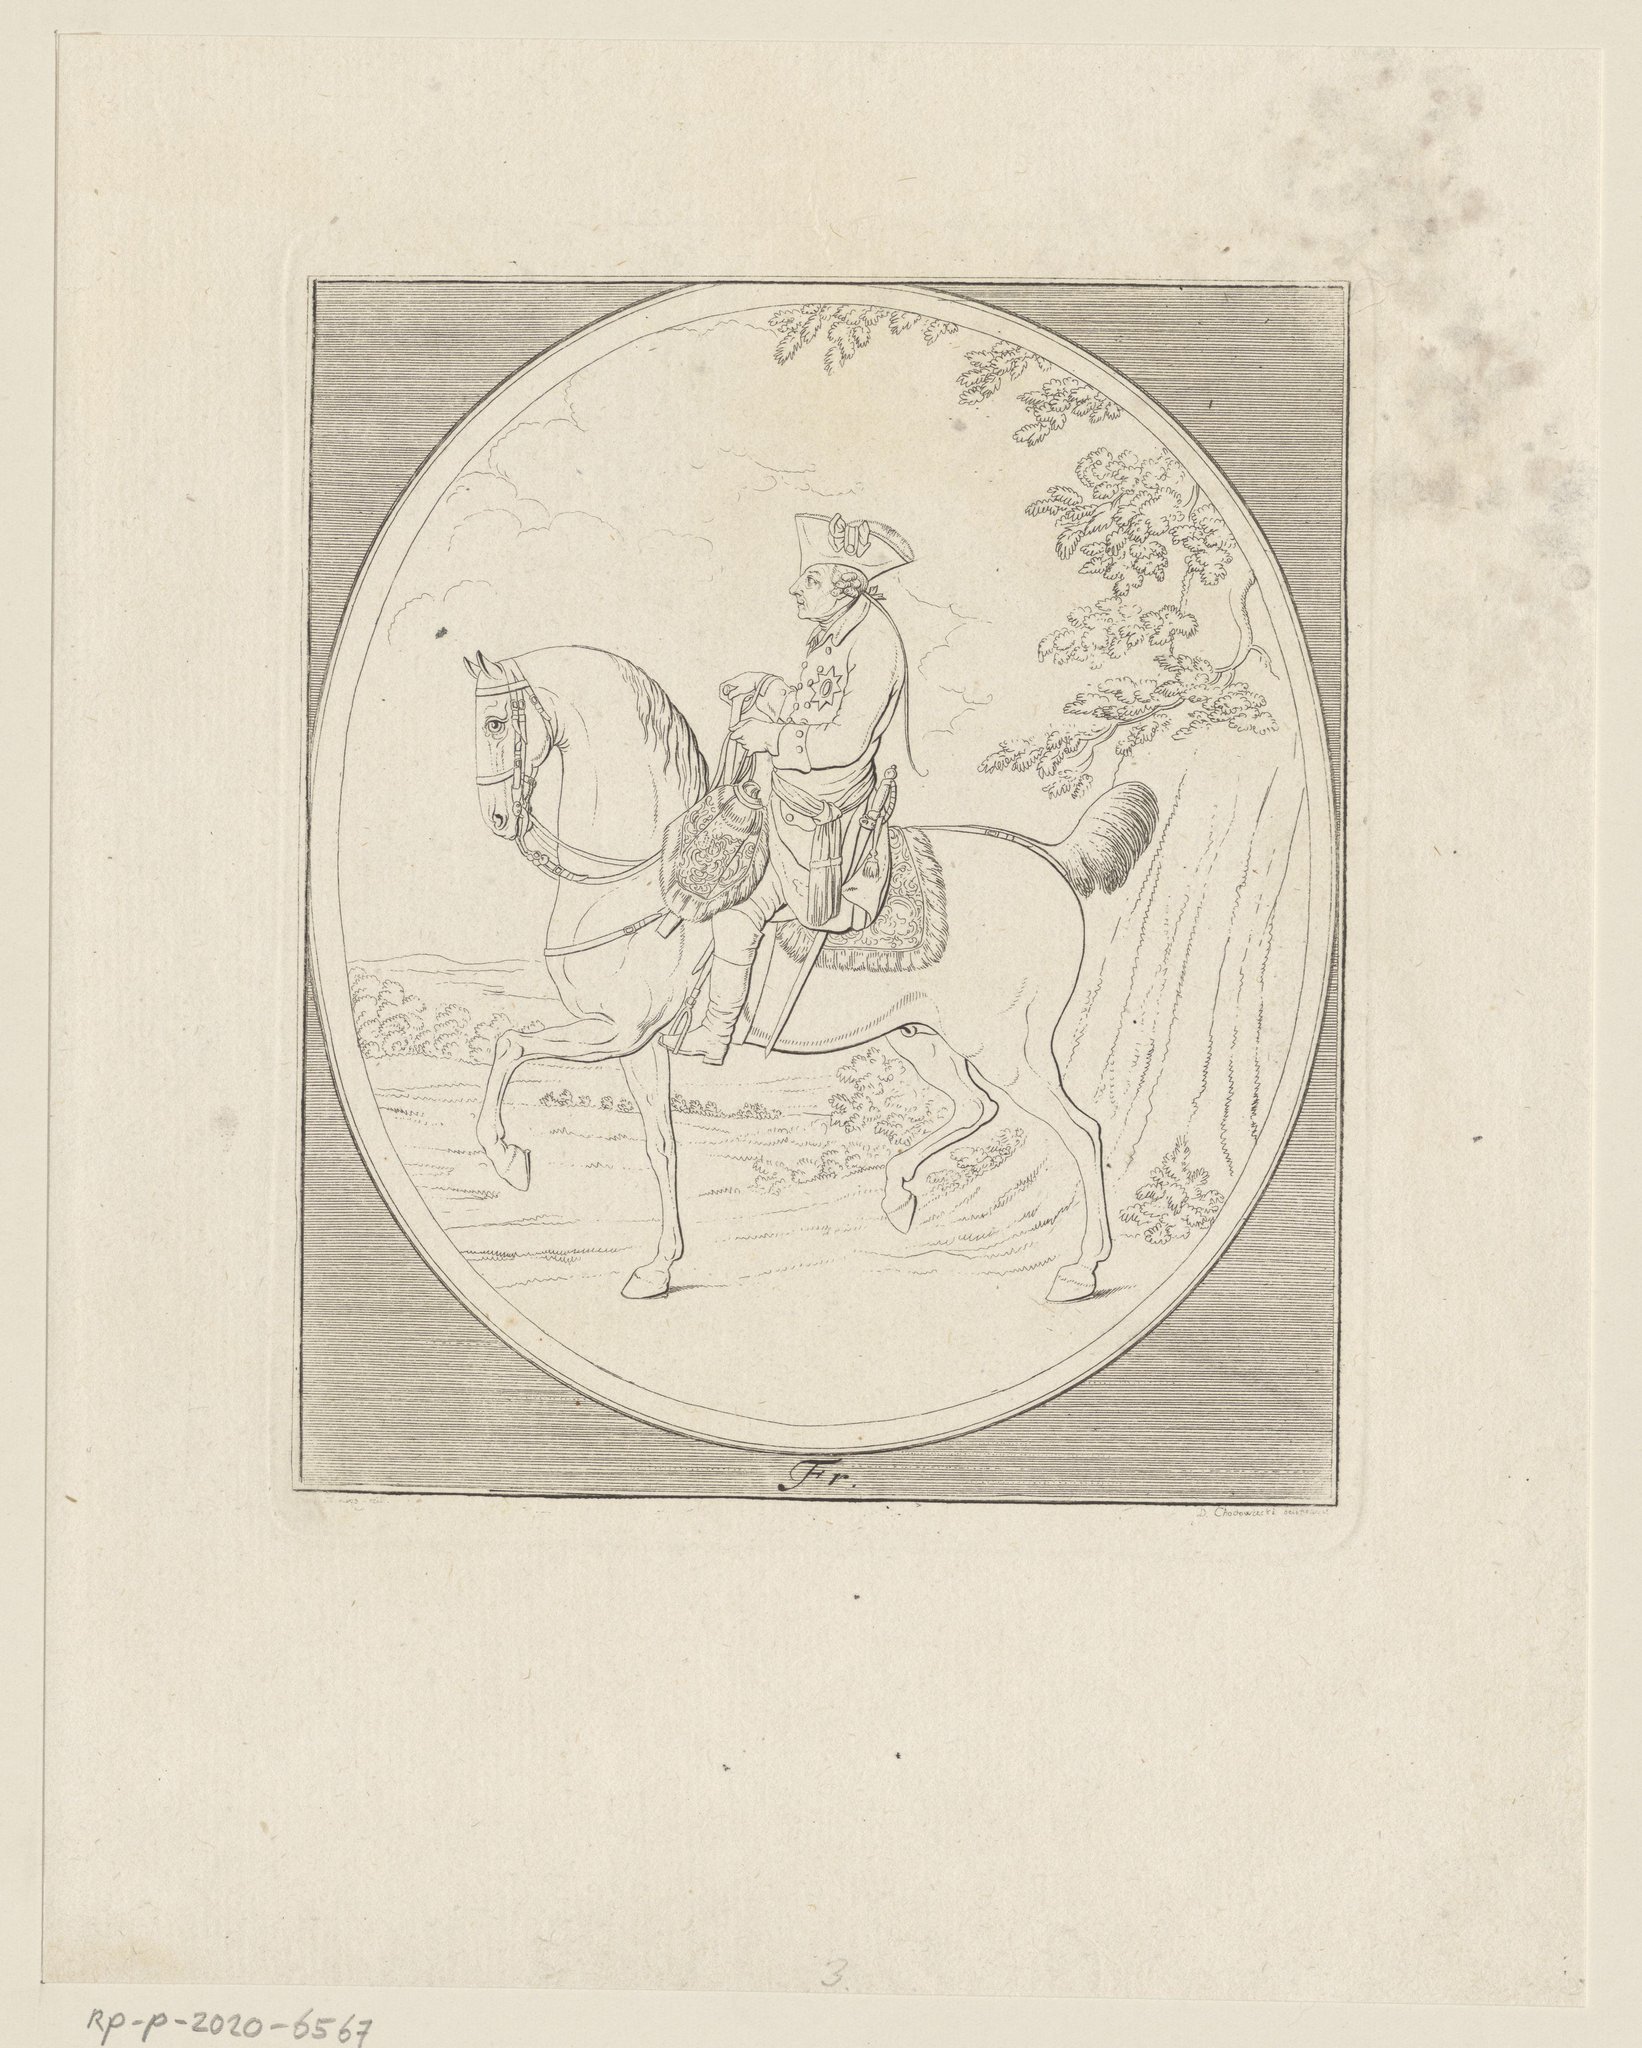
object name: print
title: Portret van Frederik de Grote te paard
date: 1777-1800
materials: paper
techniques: etching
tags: berlin, frederick ii (king of prussia), equestrian state-portrait, historical persons, (military) uniforms, king